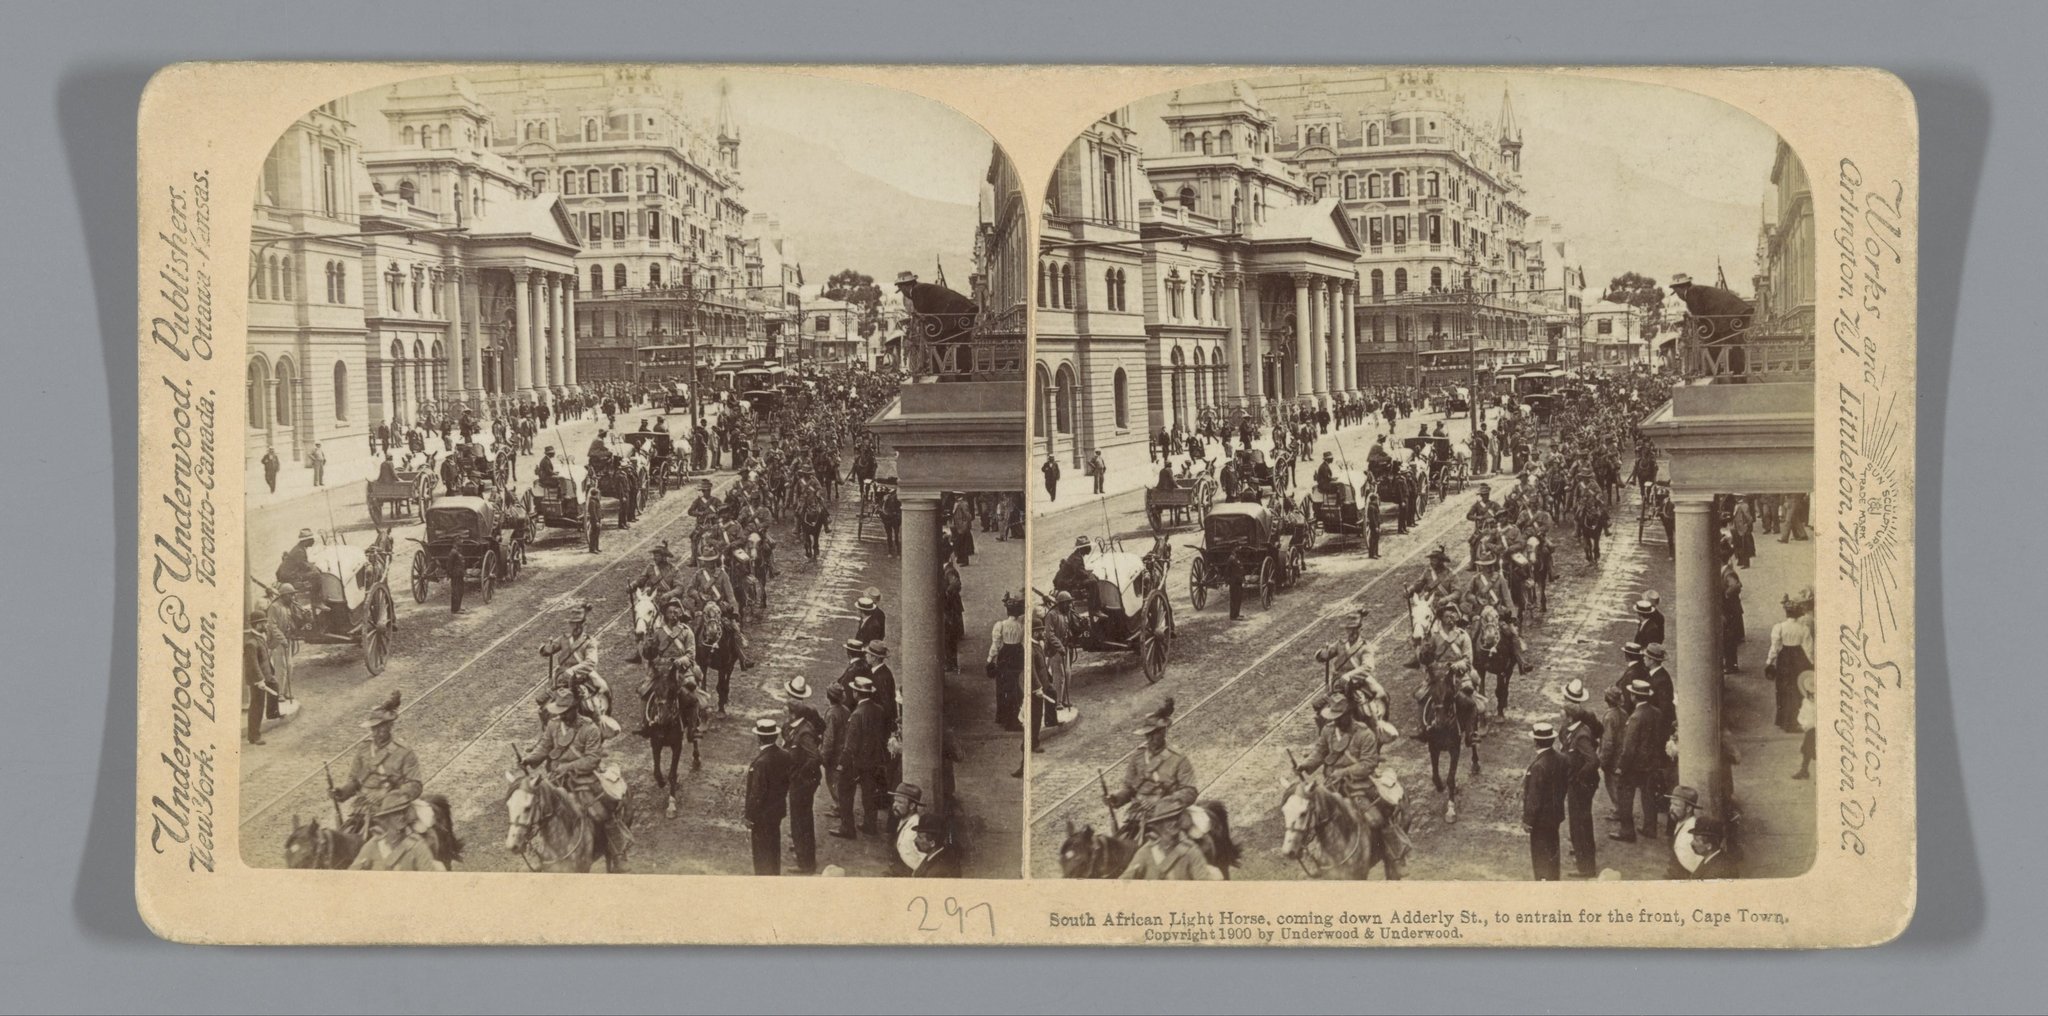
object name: stereograph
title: South African Light Horse, coming down Adderly St. to entrain for the front, Cape Town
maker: Anonymous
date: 1900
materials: cardboard, paper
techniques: albumen print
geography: new york city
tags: army 'en route', street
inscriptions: inscription, inscription: ‘Works and Studios ~/ Arlington, N.J. Littleton, N.H. Washington, D.C.’, number: ‘297’, copyright notice: ‘Copyright 1900 by Underwood & Underwood.’